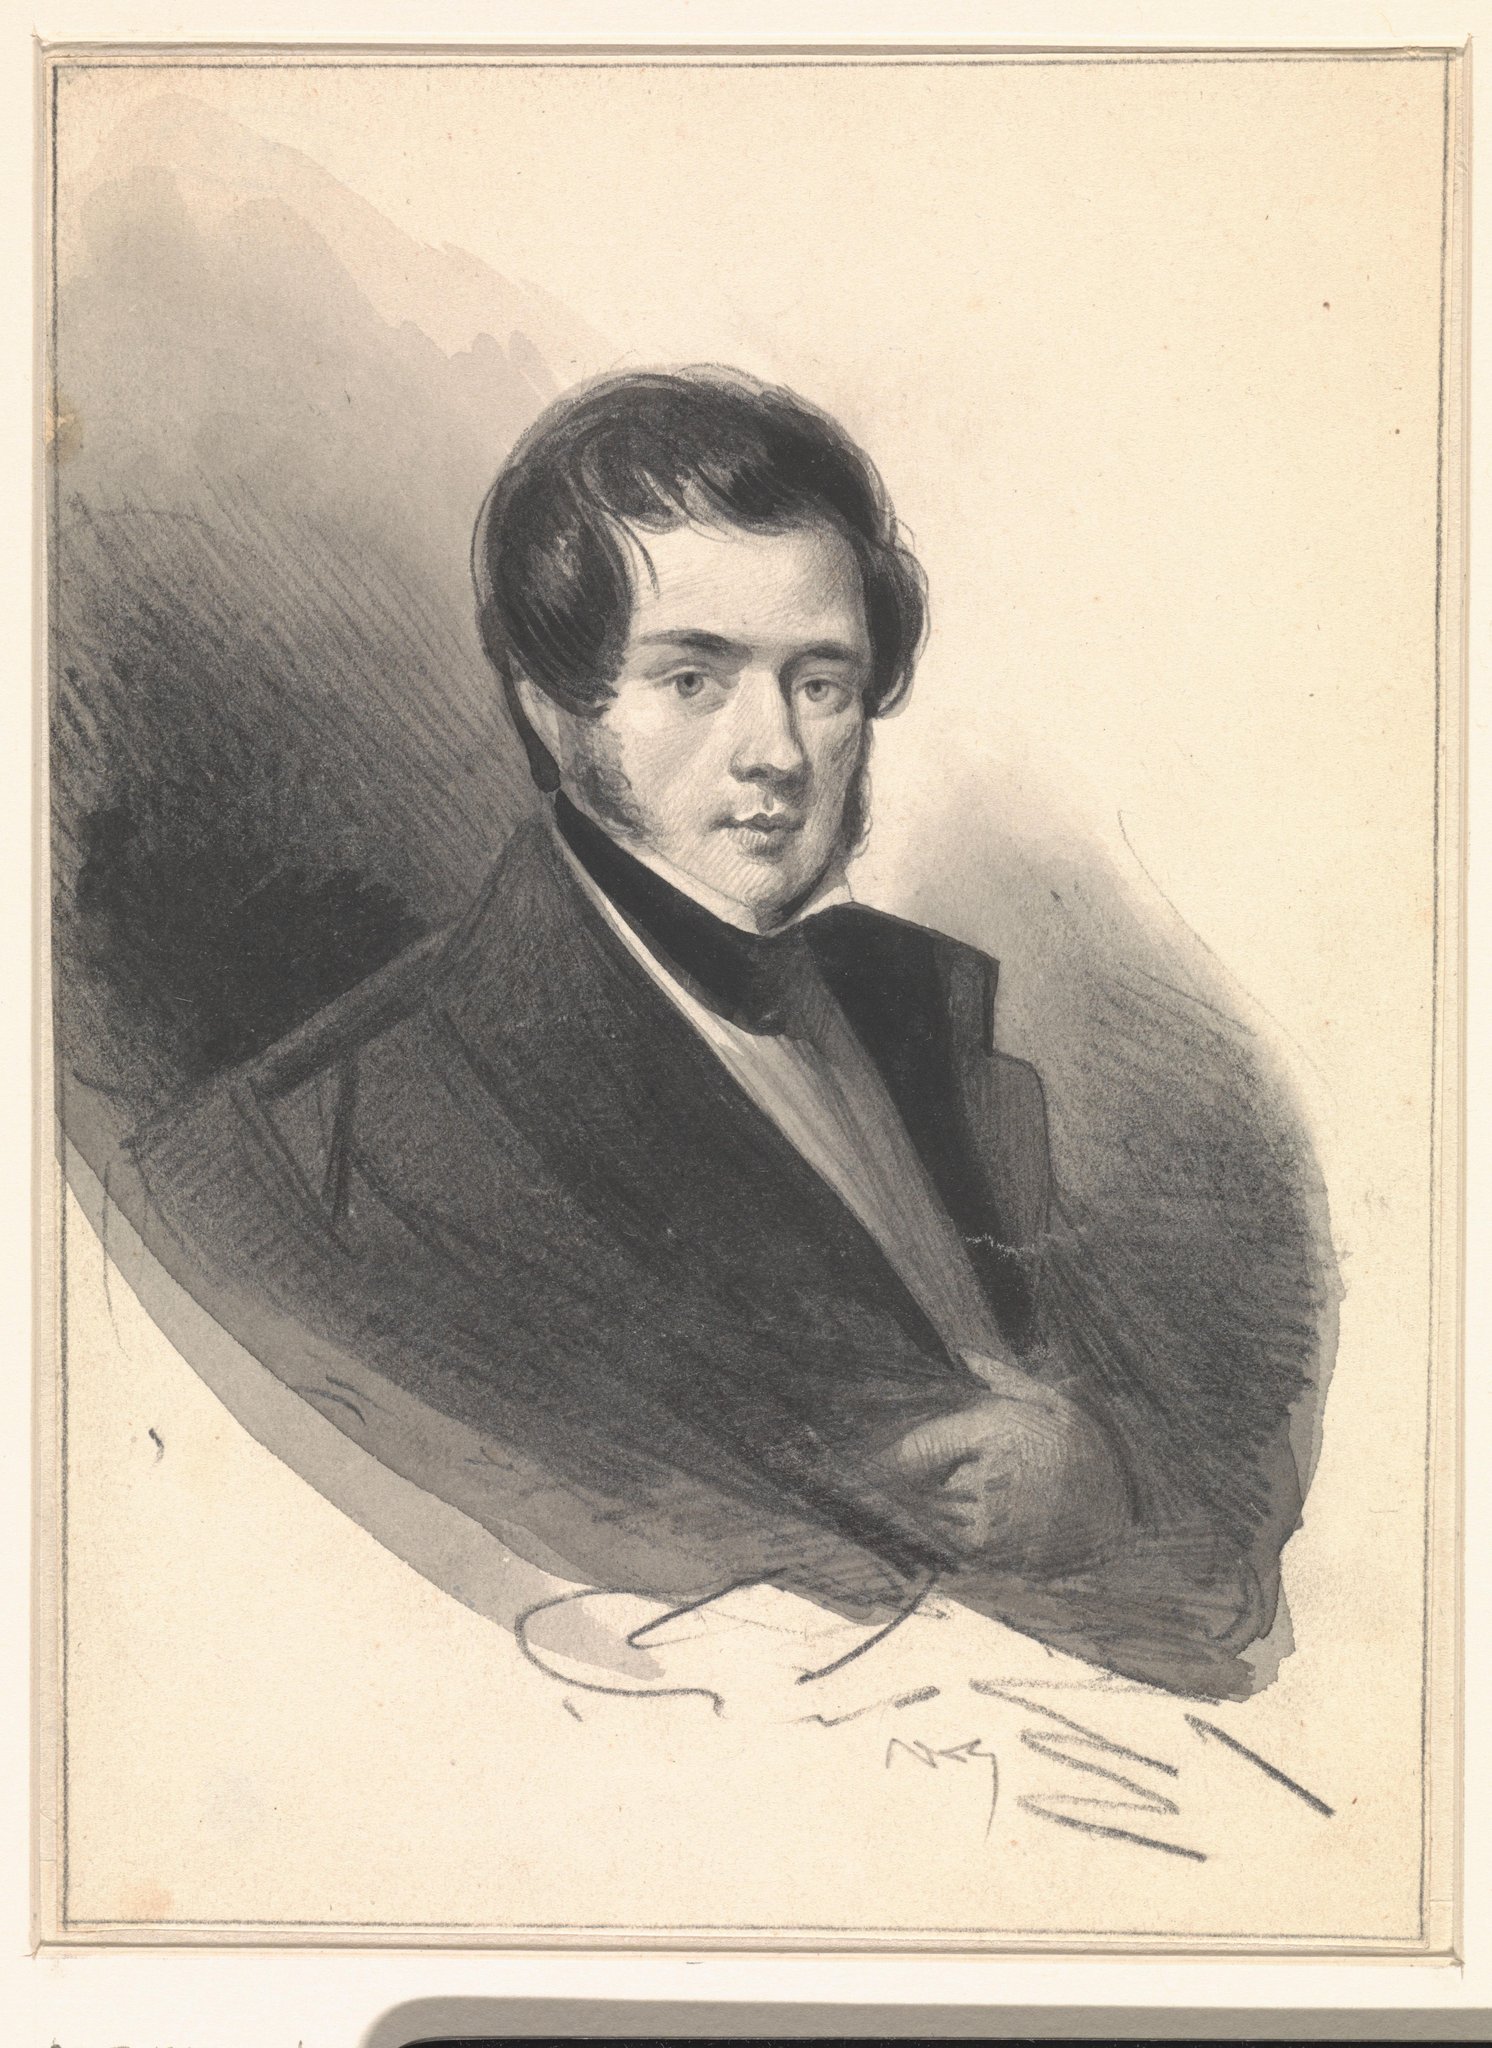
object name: drawing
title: Portret van George Gillis Haanen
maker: Anonymous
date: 1817-1900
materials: ink, paper, pencil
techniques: brush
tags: utrecht, painter, print maker, draughtsman, george gillis haanen, historical persons, portrait, self-portrait of painter, portrait, self-portrait of artist, portrait, self-portrait of draughtsman